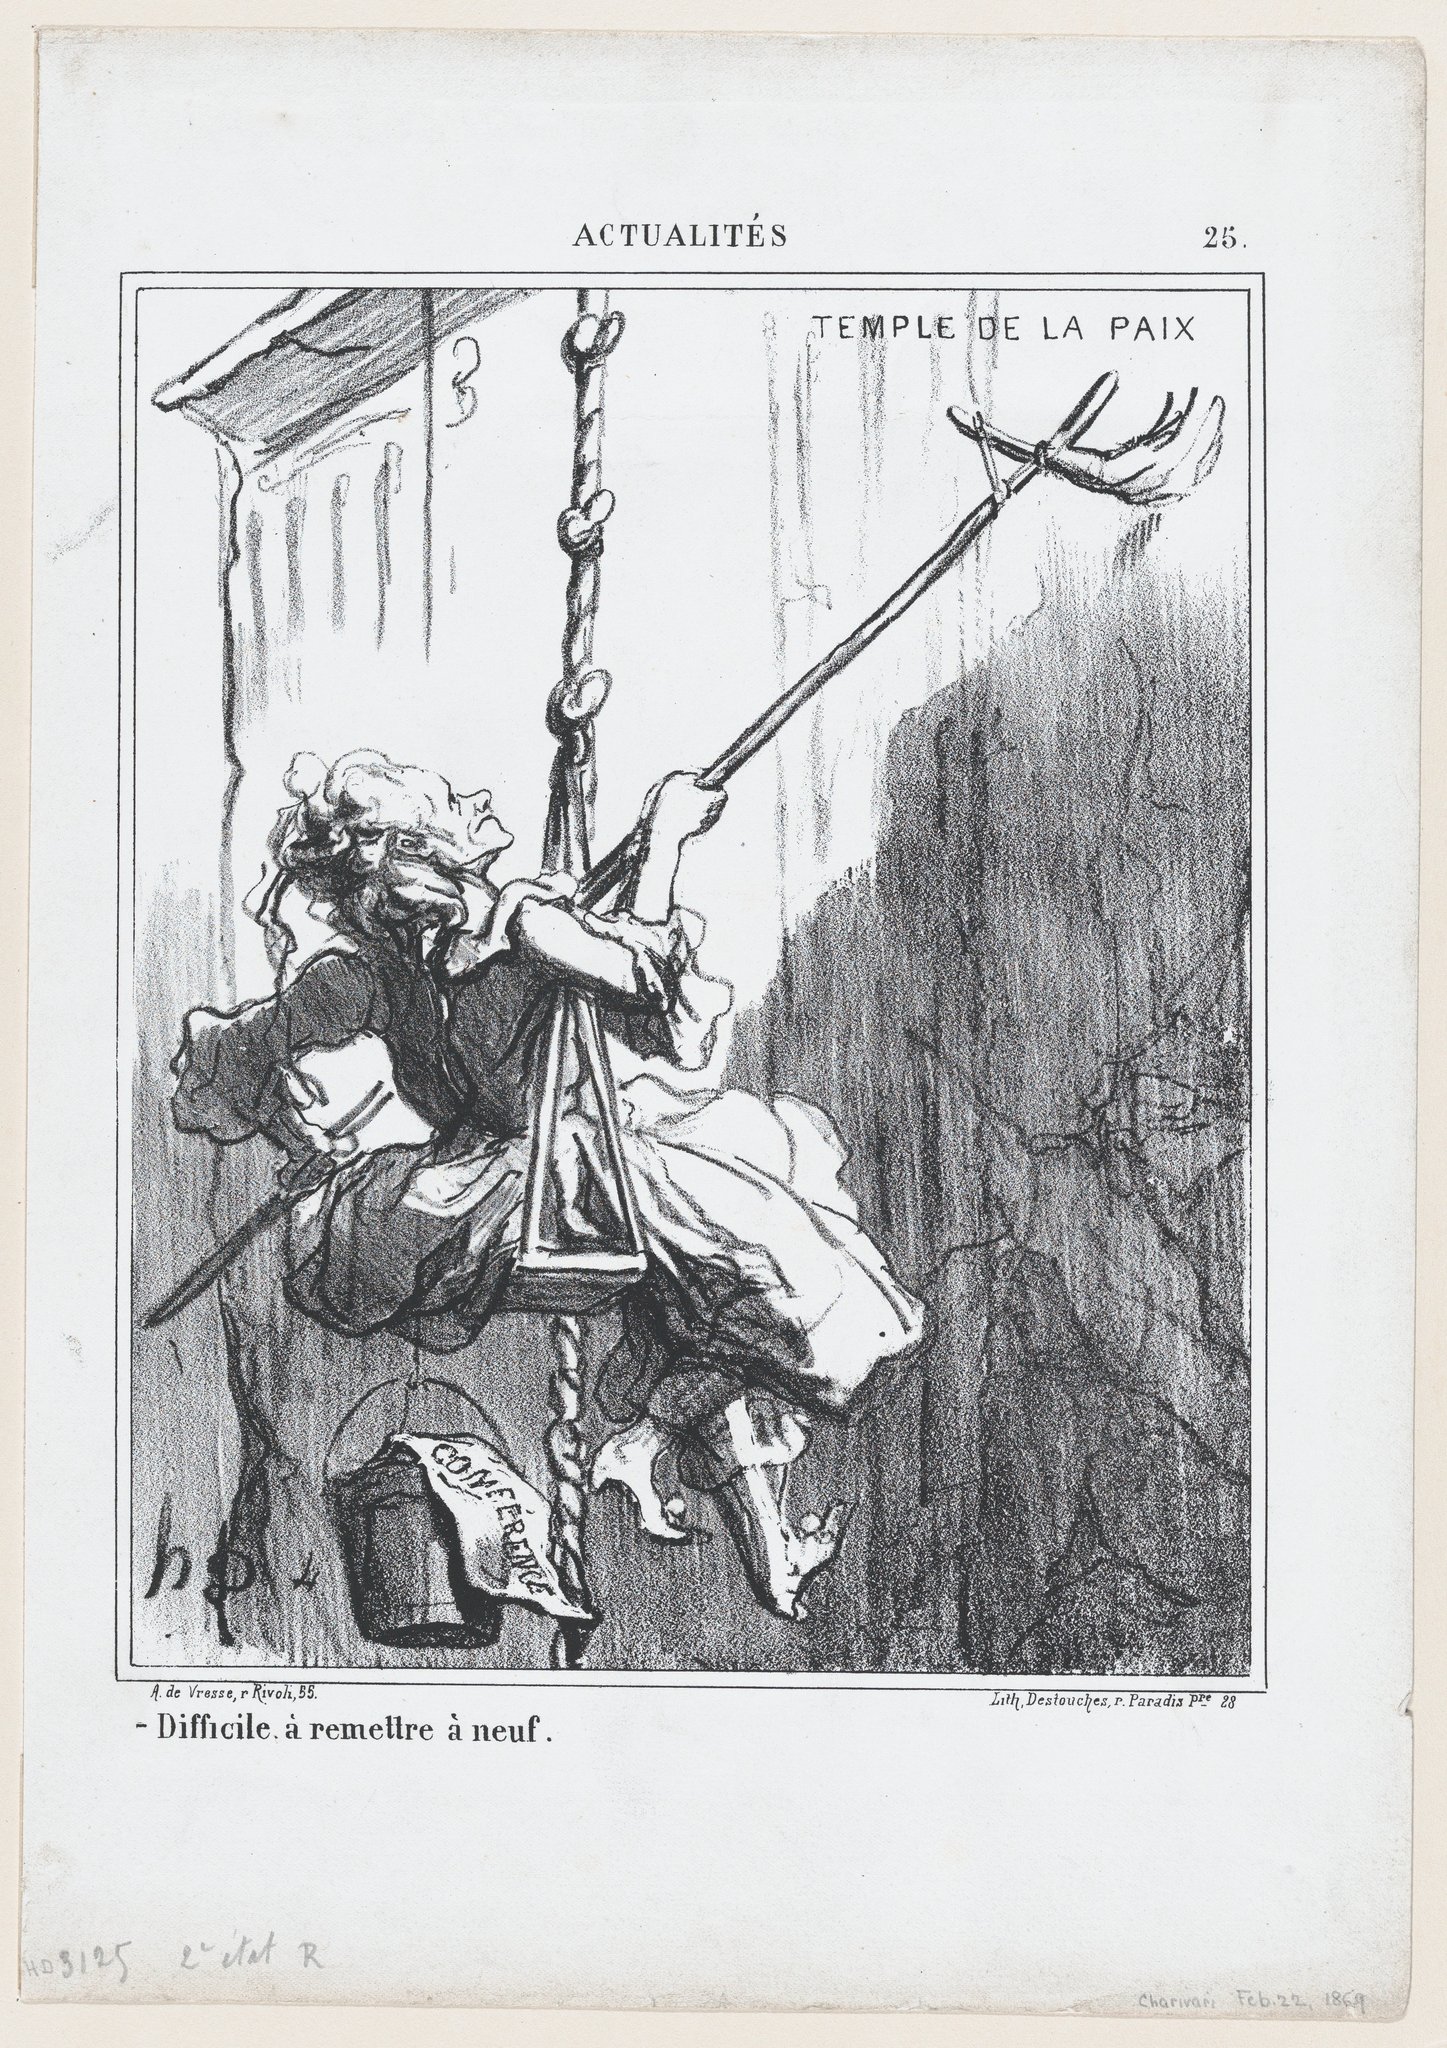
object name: print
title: Difficult to restore it to be like new, from 'News of the day,' published in Le Charivari, February 22, 1869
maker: honoré daumier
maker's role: artist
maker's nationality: french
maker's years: 1808-1879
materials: paper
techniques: lithograph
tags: satire,women